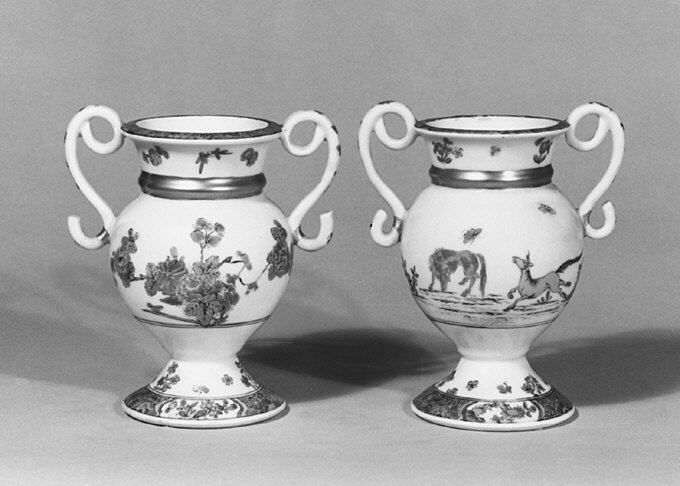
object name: vase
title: Vase (one of a pair)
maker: meissen manufactory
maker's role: manufactory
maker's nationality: german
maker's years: 1710-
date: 1735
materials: hard paste porcelain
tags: horses,flowers